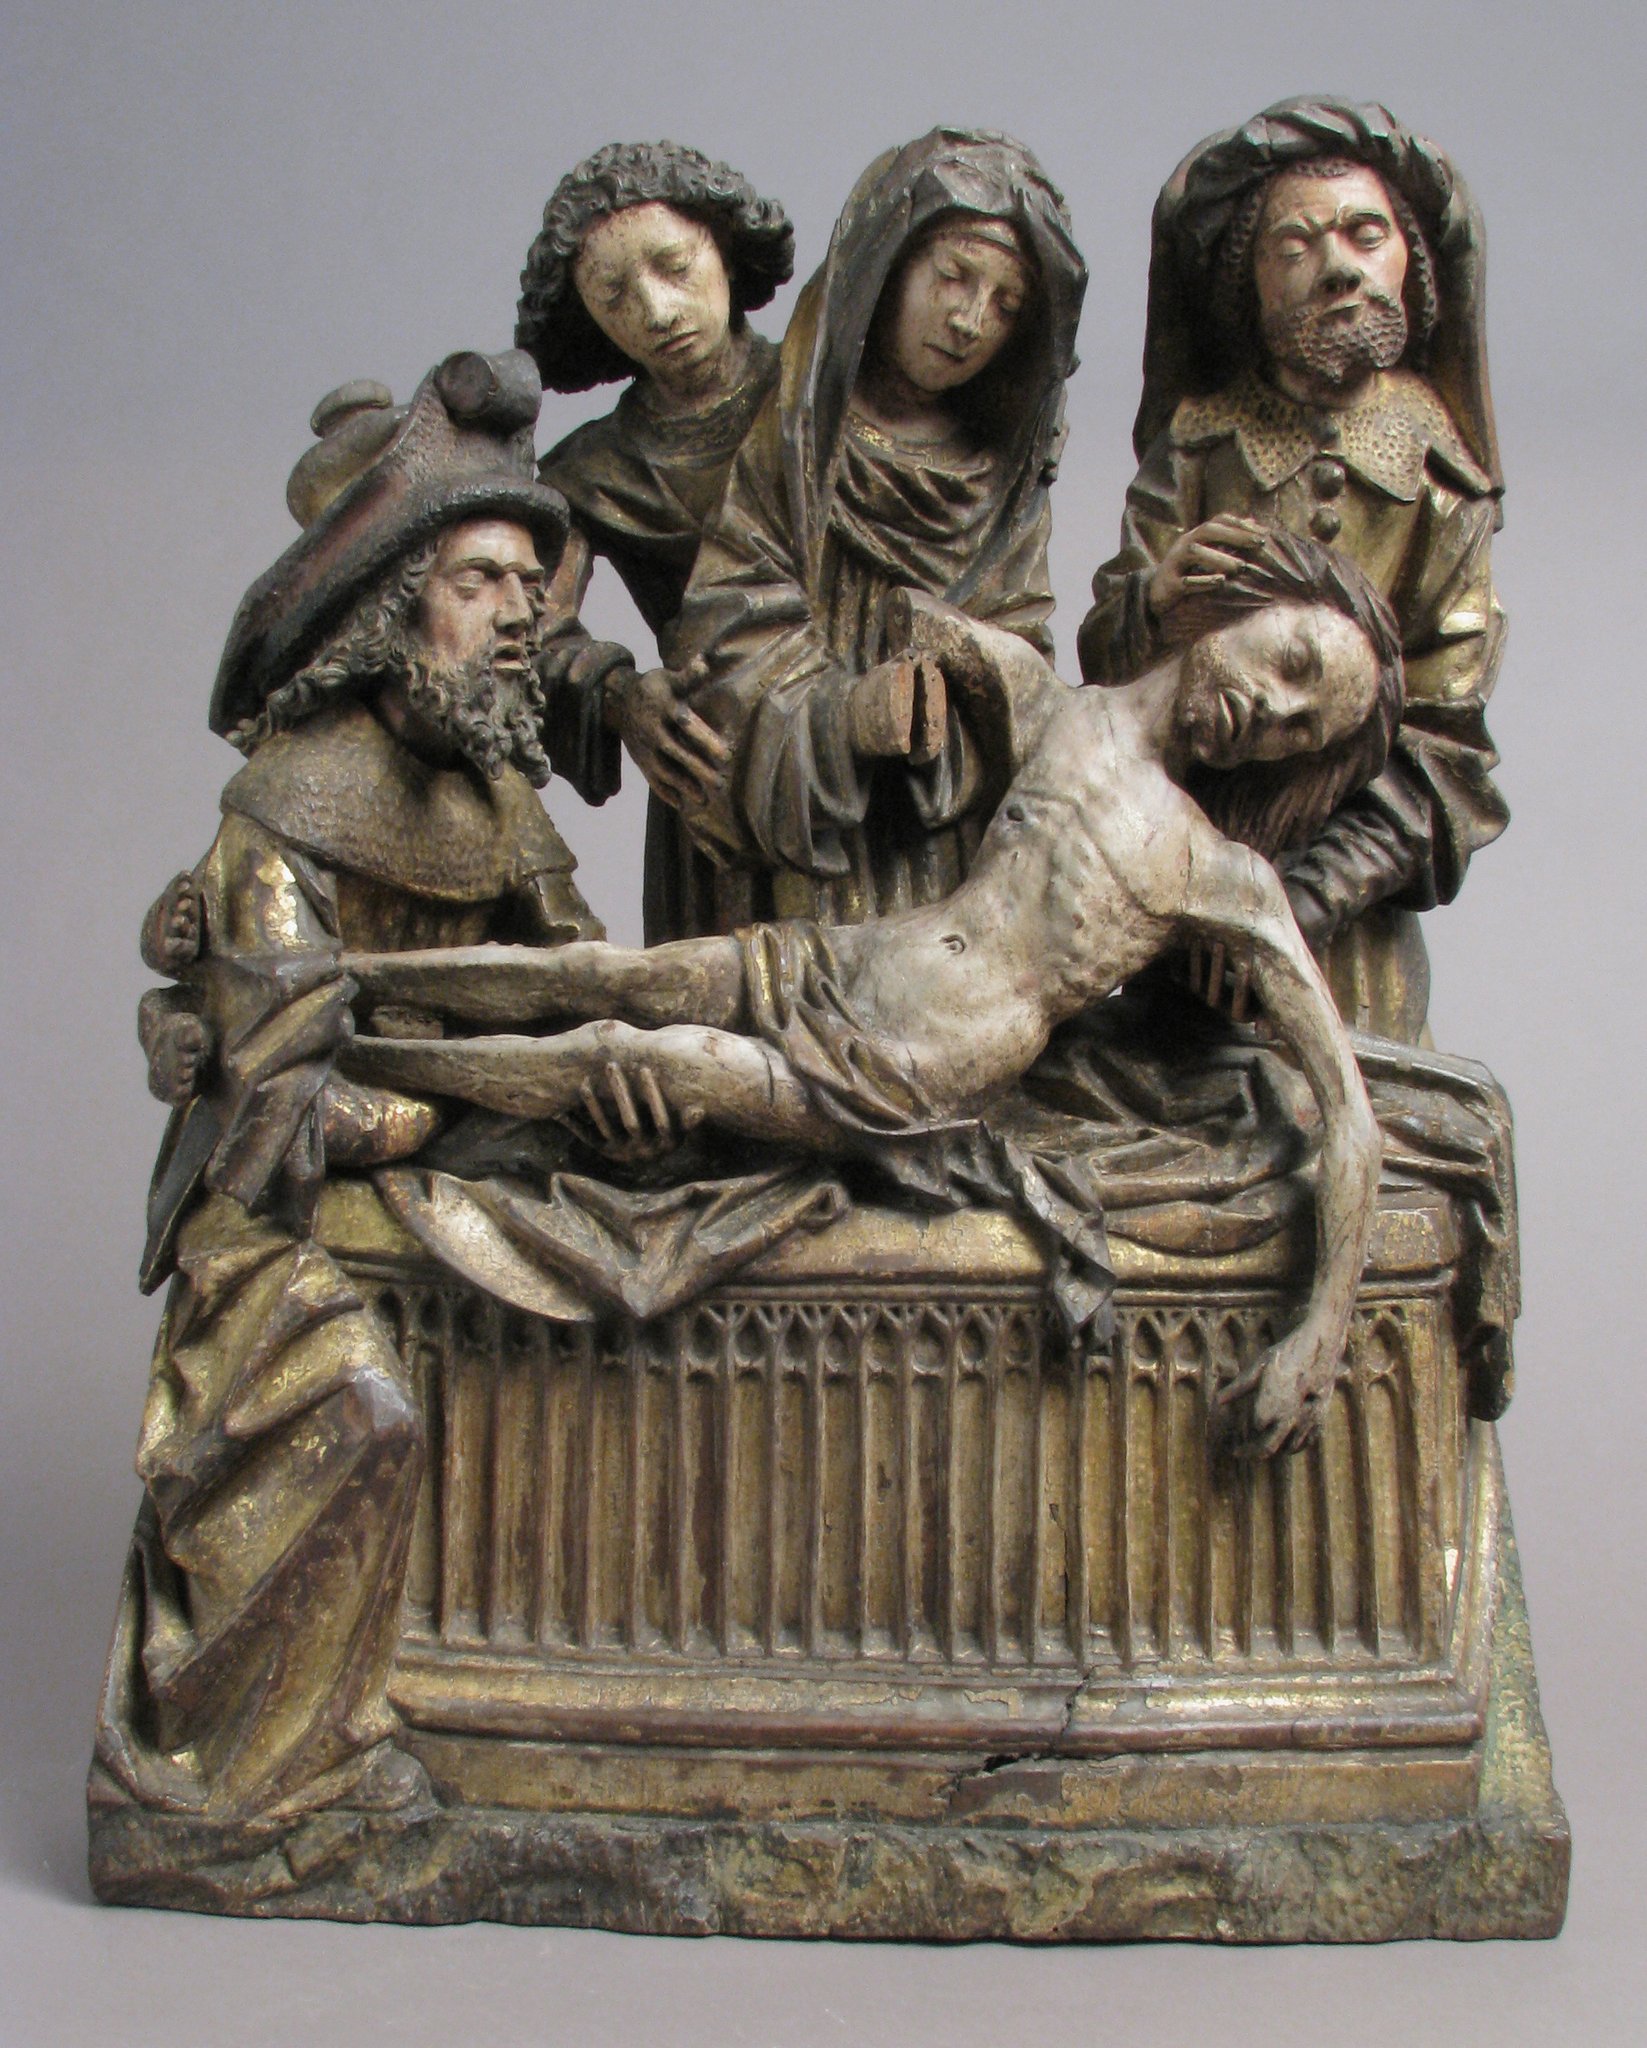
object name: relief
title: The Entombment of Christ with the Virgin Mary, Saint John, Nicodemus, and Joseph of Arimathea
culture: french, north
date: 1500-1510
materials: wood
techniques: gilding, polychromy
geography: france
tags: christ,entombment